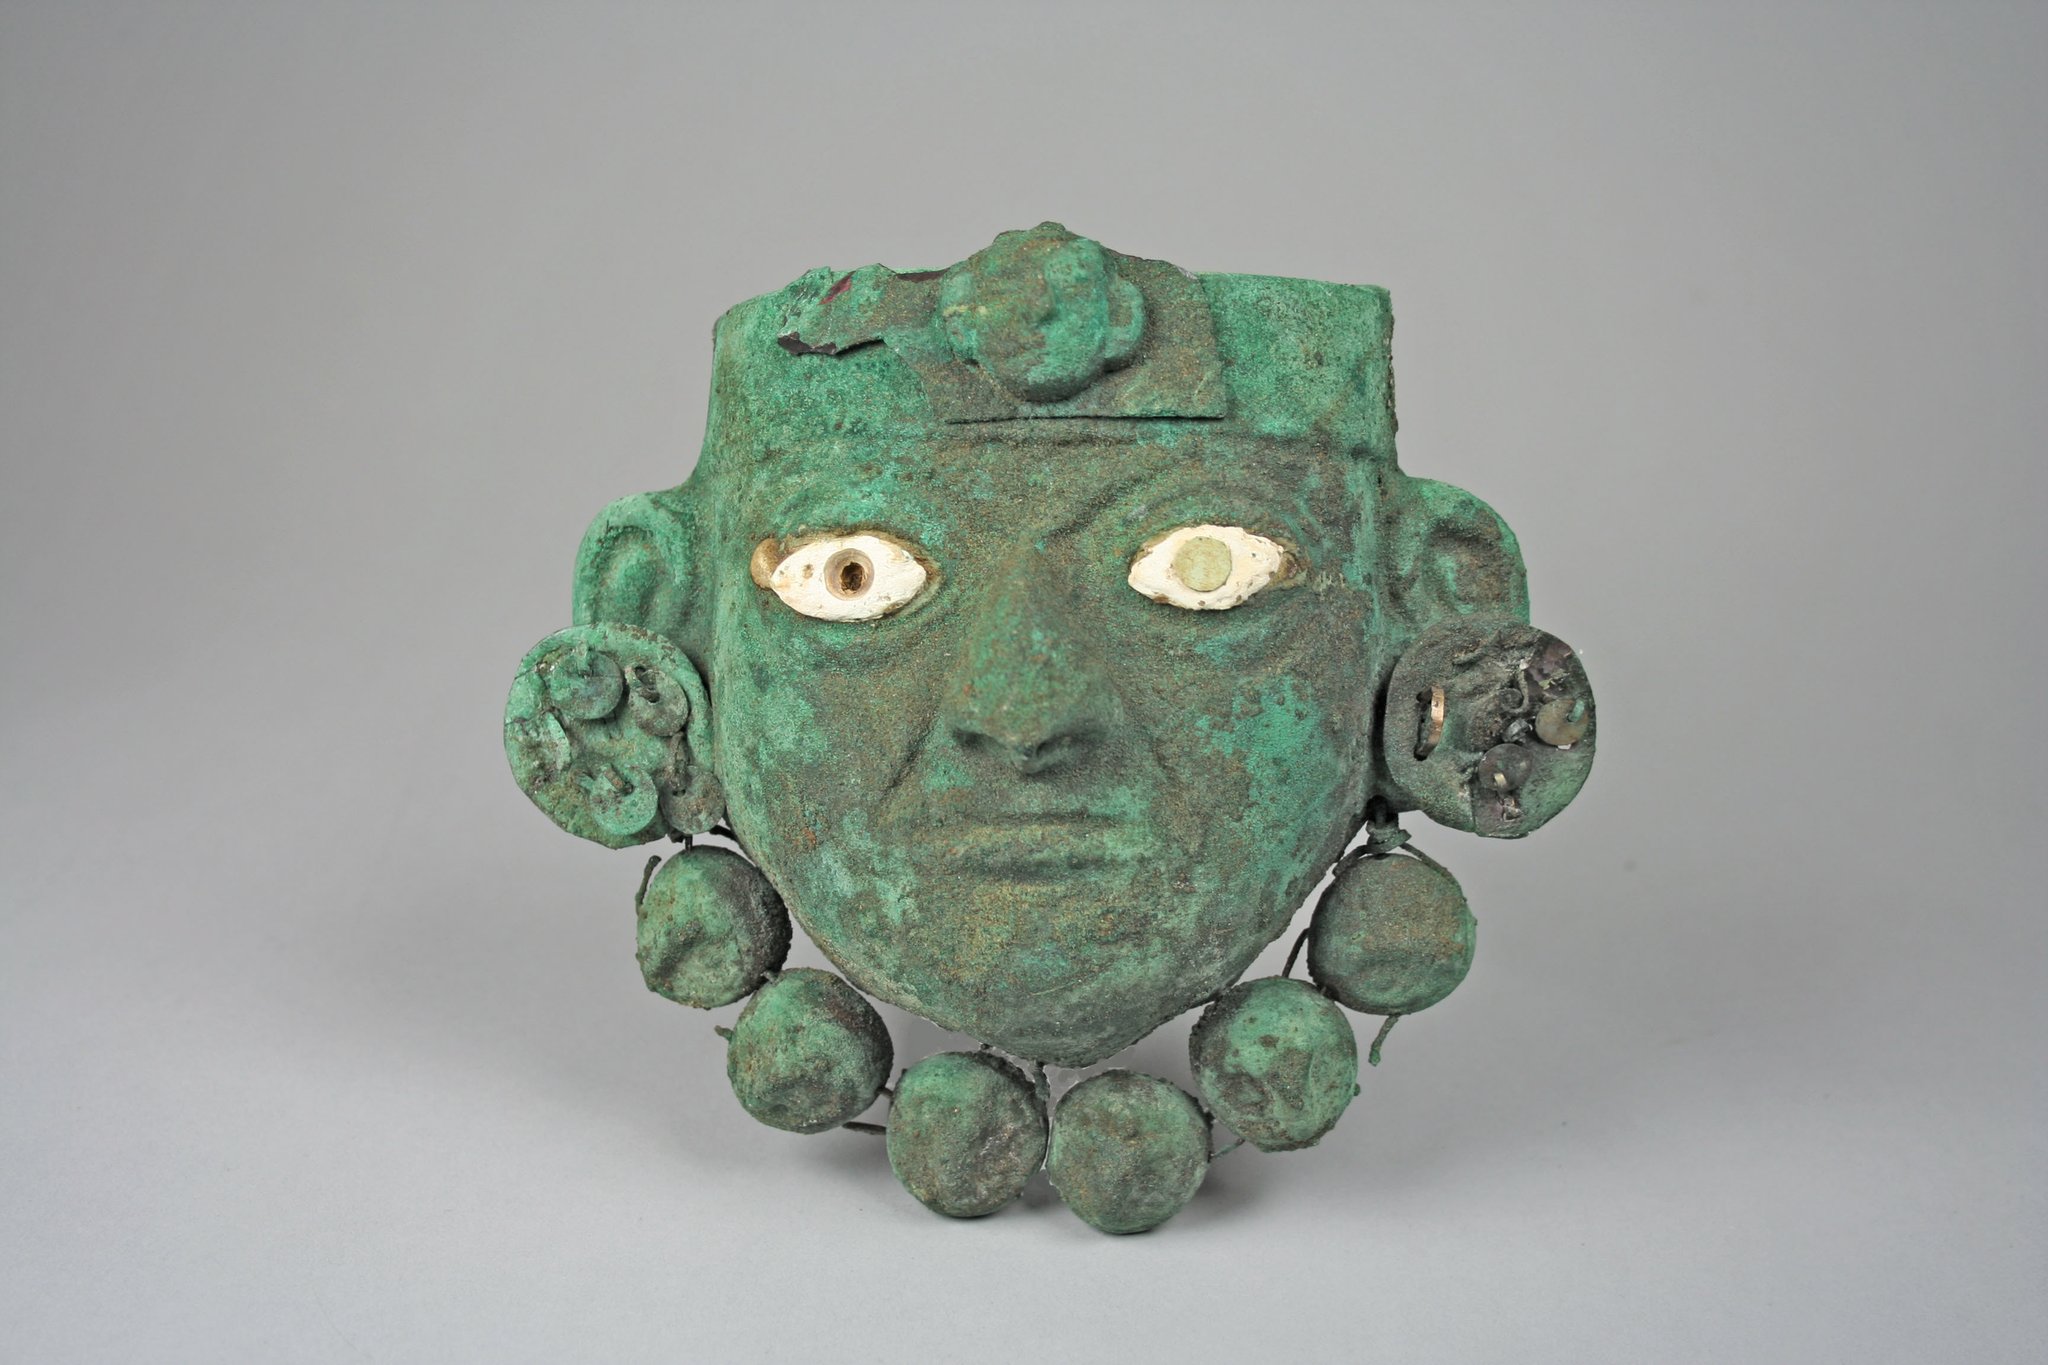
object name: ornament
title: Mask Ornament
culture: moche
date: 501-700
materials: copper, shell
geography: peru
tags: faces